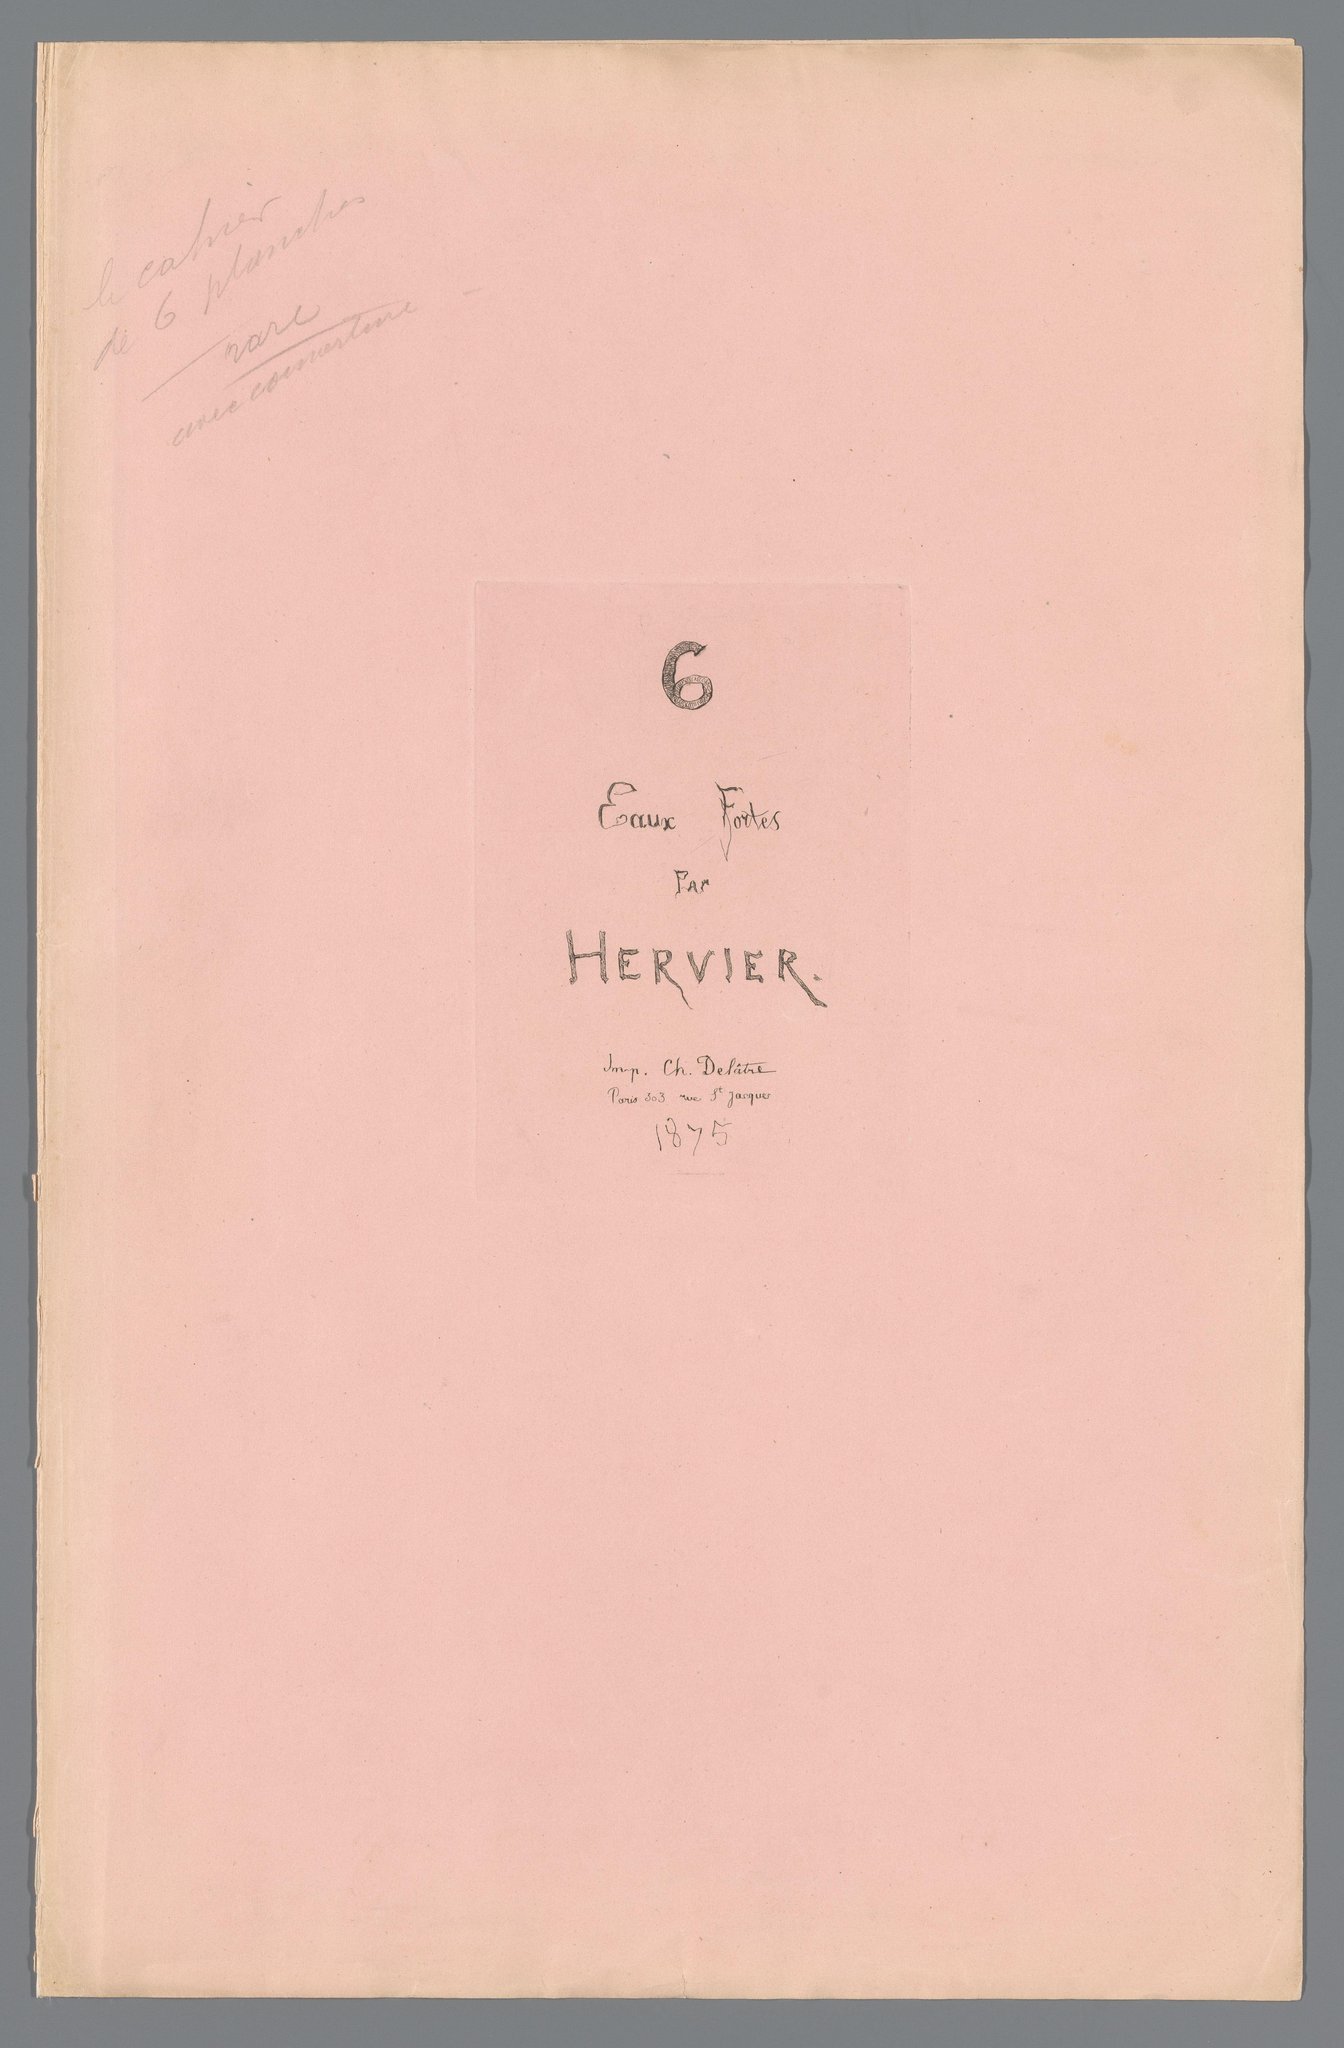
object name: print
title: Collectie prenten door Hervier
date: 1875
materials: paper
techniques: etching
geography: paris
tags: letters, alphabet, script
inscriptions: inscription: ‘le cahier/ de 6 planches/ rare/ [...]’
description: In deze omslag bevindt zich een zesdelige serie prenten met verschillende onderwerpen, samengesteld en uitgevoerd door Hervier.